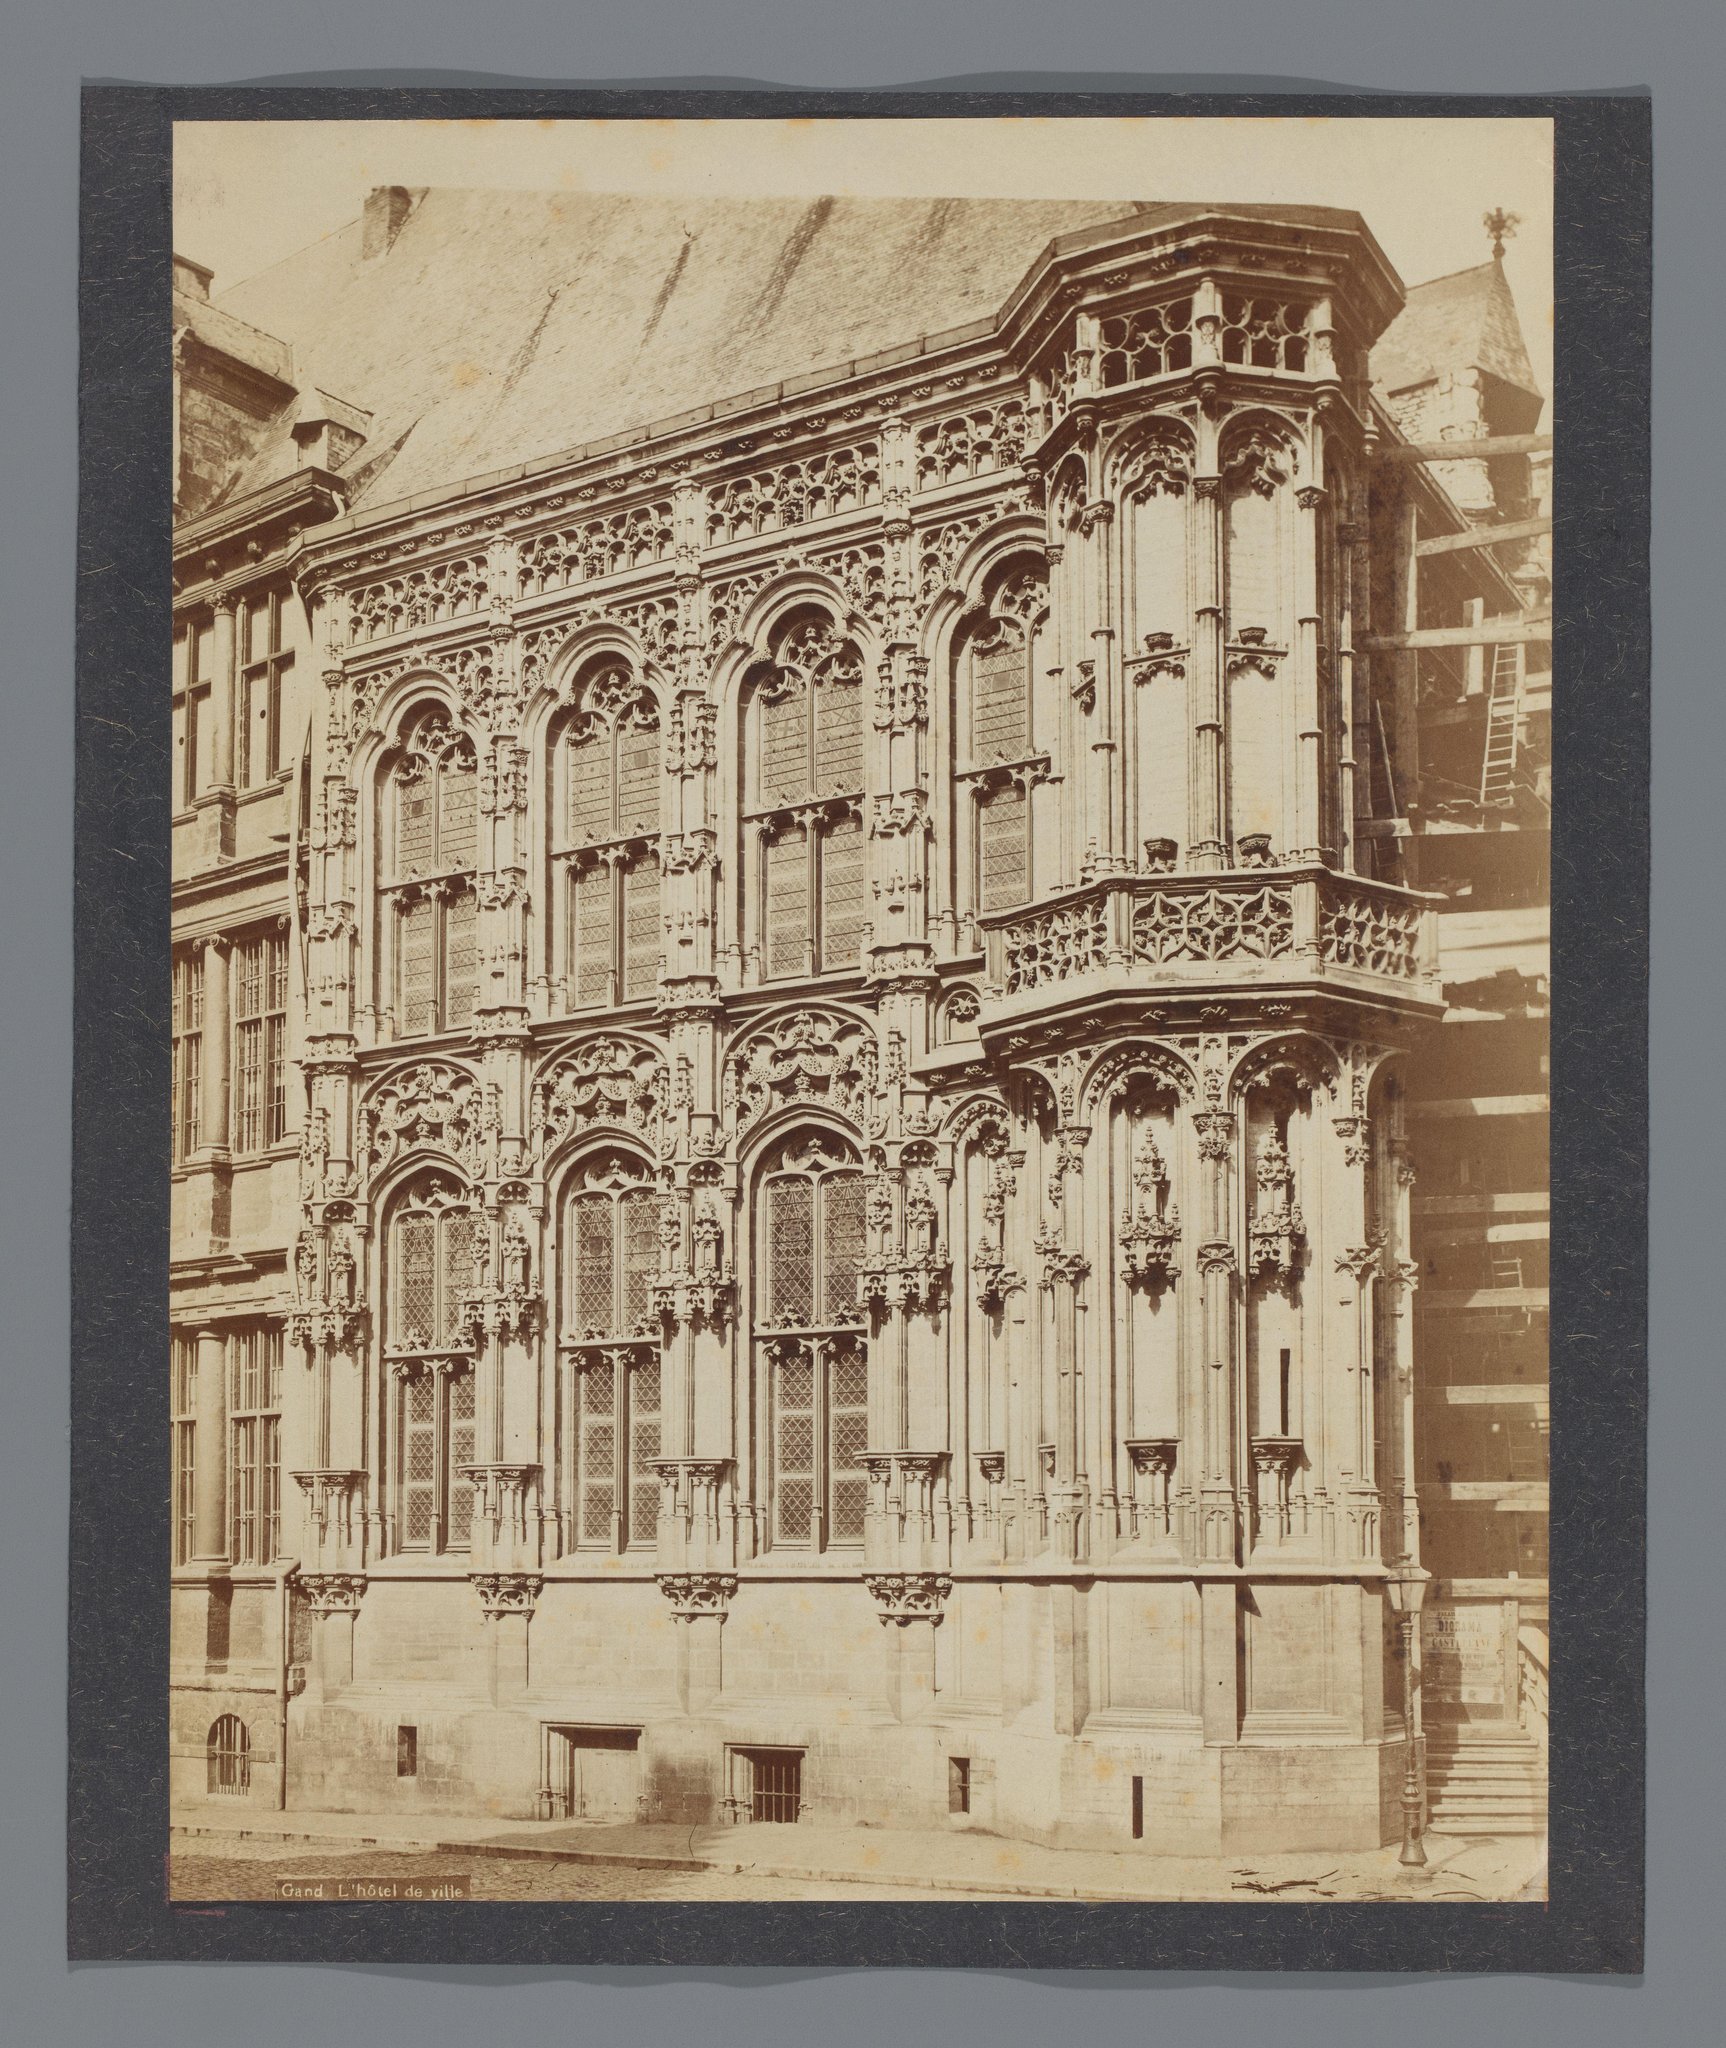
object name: photograph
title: Gent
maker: Anonymous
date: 1850-1900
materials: photographic support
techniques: albumen print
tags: ghent